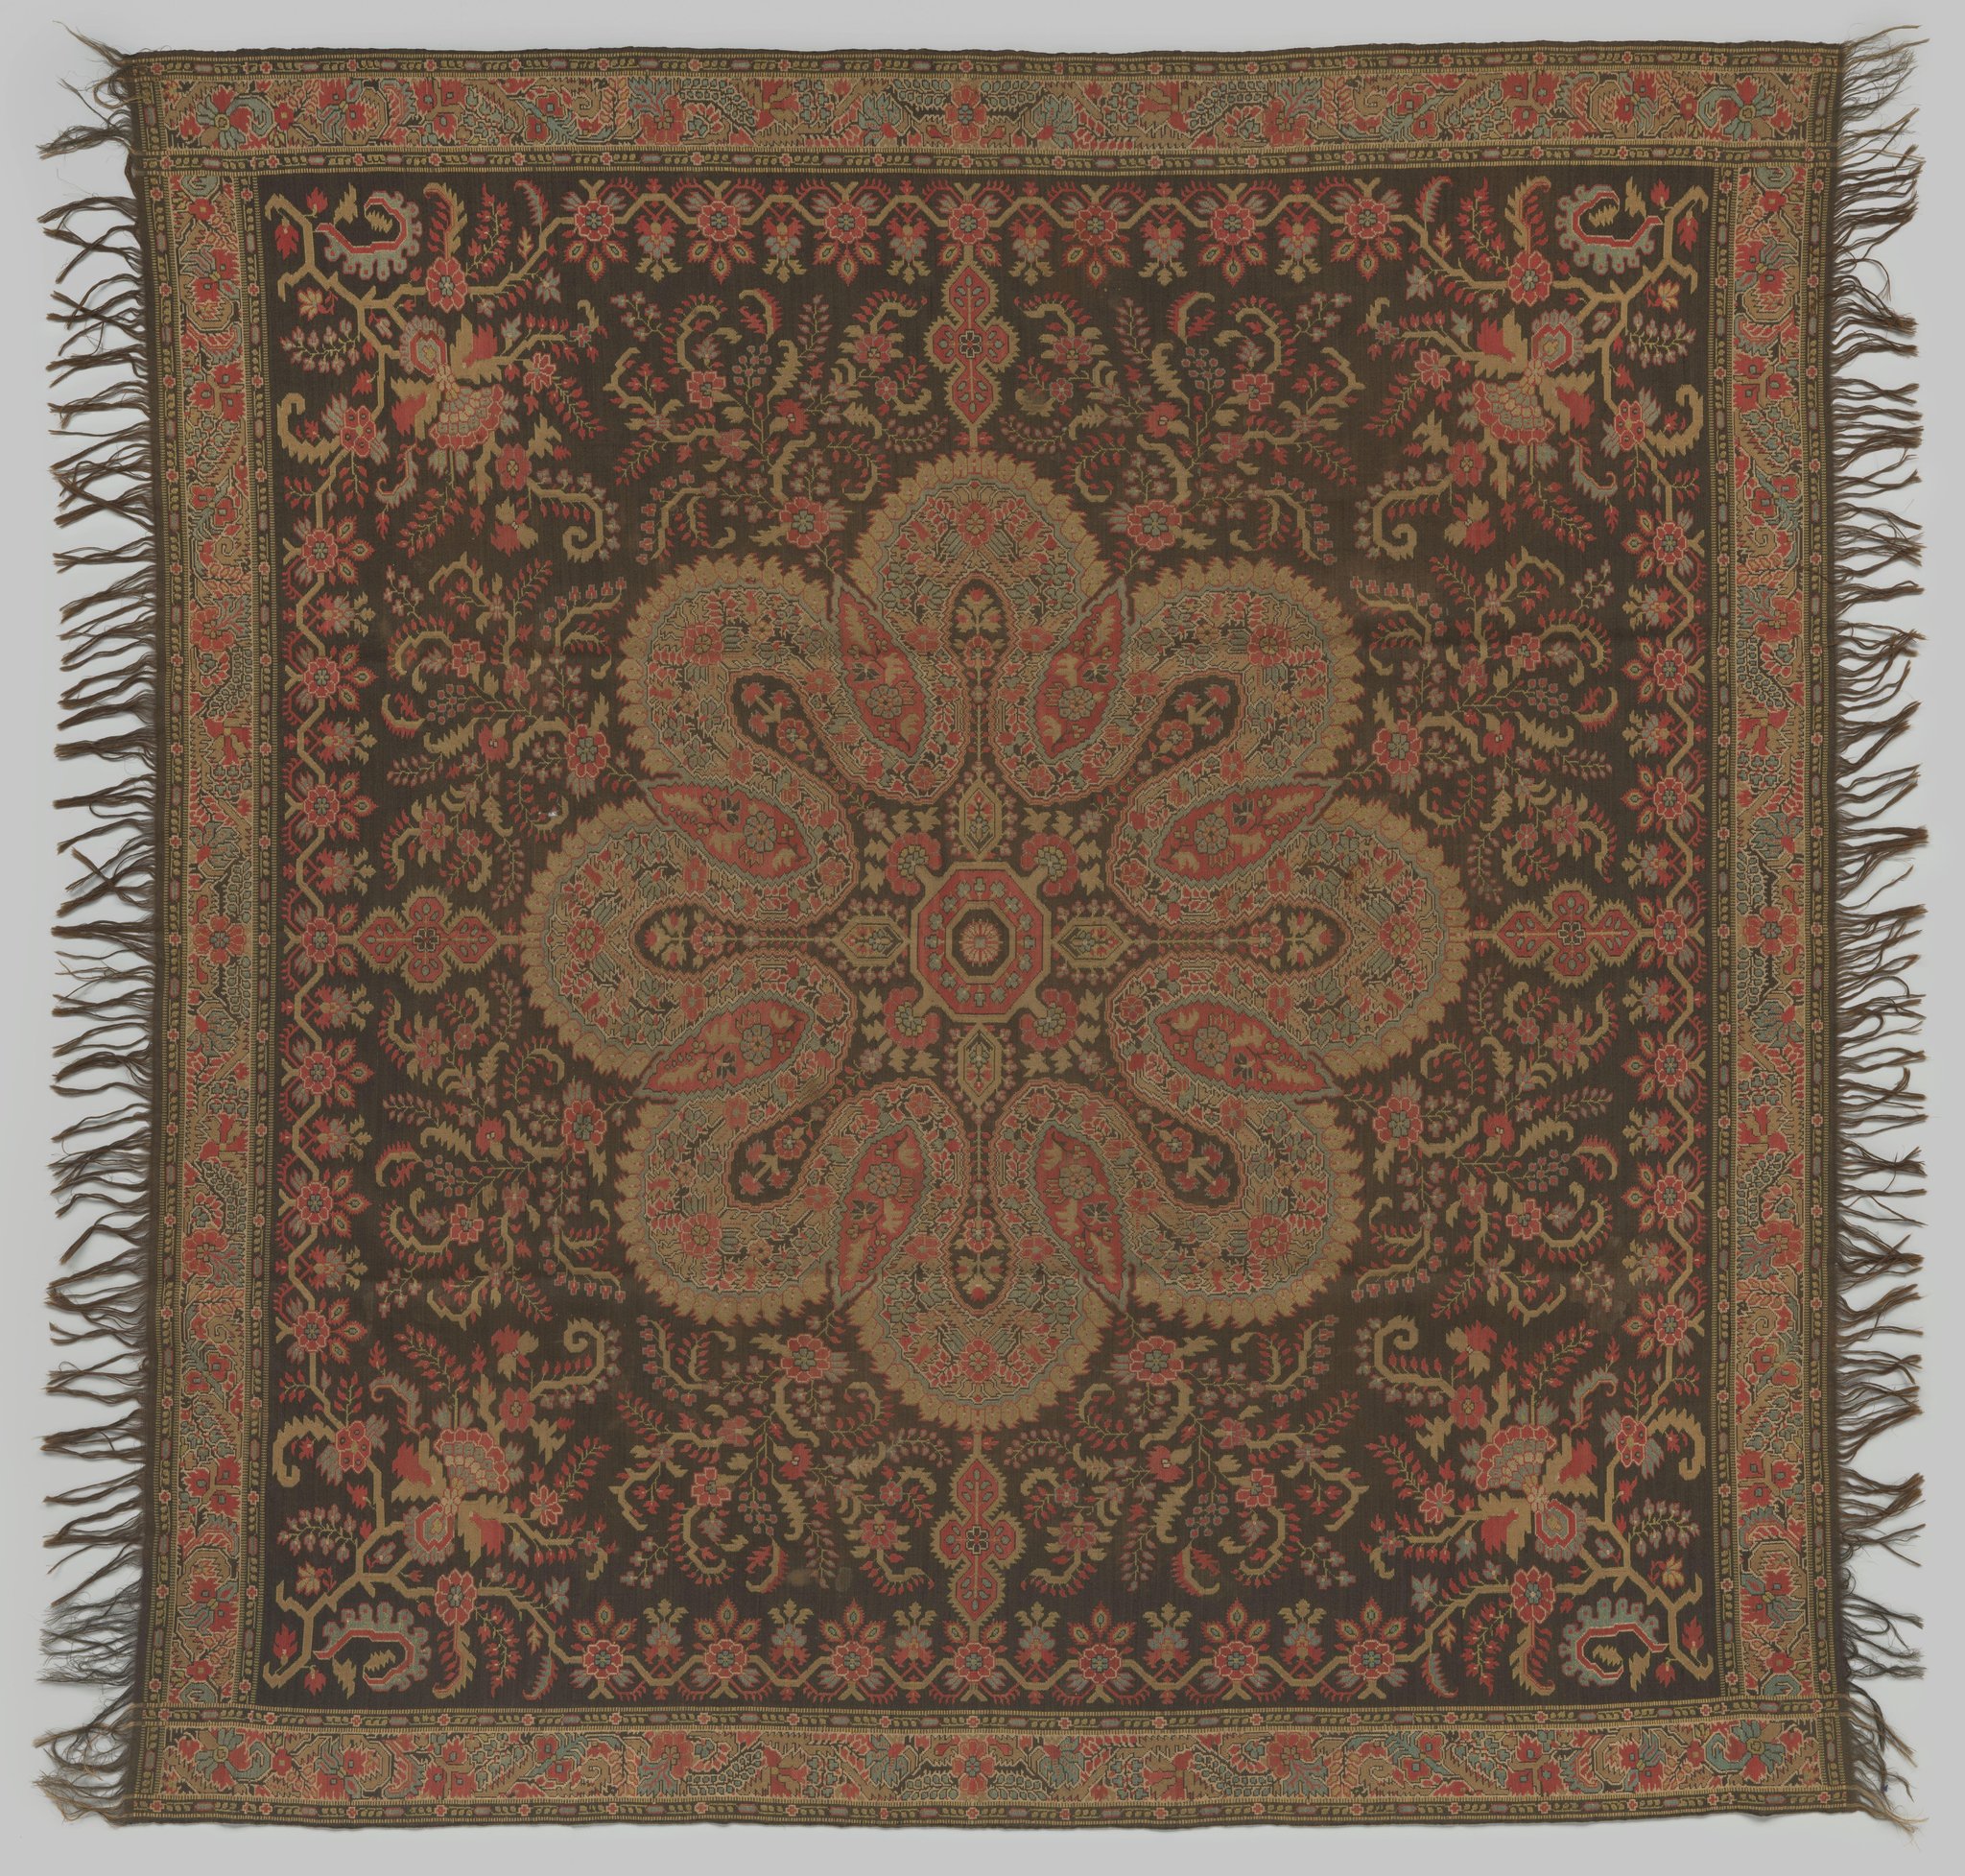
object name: clothing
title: Vierkante kasjmiersjaal met achtlobbige rozet, veelkleurig en versierd met bloesemtakken en dubbelranken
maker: Anonymous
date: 1830-1840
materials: wool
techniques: weave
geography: austria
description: Palmenshawl, geweven van wol , vierkant, met een vol patroon met zwarte fond waarop een grote achtlobrige licht groene binnen rozet met rode, gele vaalblauwe bloempjes, terwijl op het veld open bloesem takken staan, binnen hoekige dubbelranken, met smalle witte buitenrand. Techniek. Keperbinding: De inslag is aan de achterzijde hier en daar gelanceerd, maar het merendeel afgesneden zwarte ketting over de volle hoogte. Patroon: Symmetrisch en hoekig getekend decor op de kruisassen. Groot zwart middenvierkant binnen smalle randen in wit, waarvan de zijranden met de biesjes de dwarsranden oversnijden. De achterzijdige golvende gelobde binnenrozet heeft lichtgroene omtrekken, een witte fond met bloesems in zwartgerand vaalblauw aan zwarte steeltjes, met rode roosjes op de golftoppen en dalen; zij laten tussenliggende spitsovalen vrij in rood met bloesems, uit deze spits en groeien acht bloesemtakken met anjertjes hyacintheen en roosjes Vanuit de hoeken staan grotere anjers in rood met witte omtrekken.Beneden een hoekige rank in mosgroen met roosje, welke een dunne rode rank oversnijdt. Buitenrand met witte fond en grillige hoekige stengels met hyacintheen en roosjes.